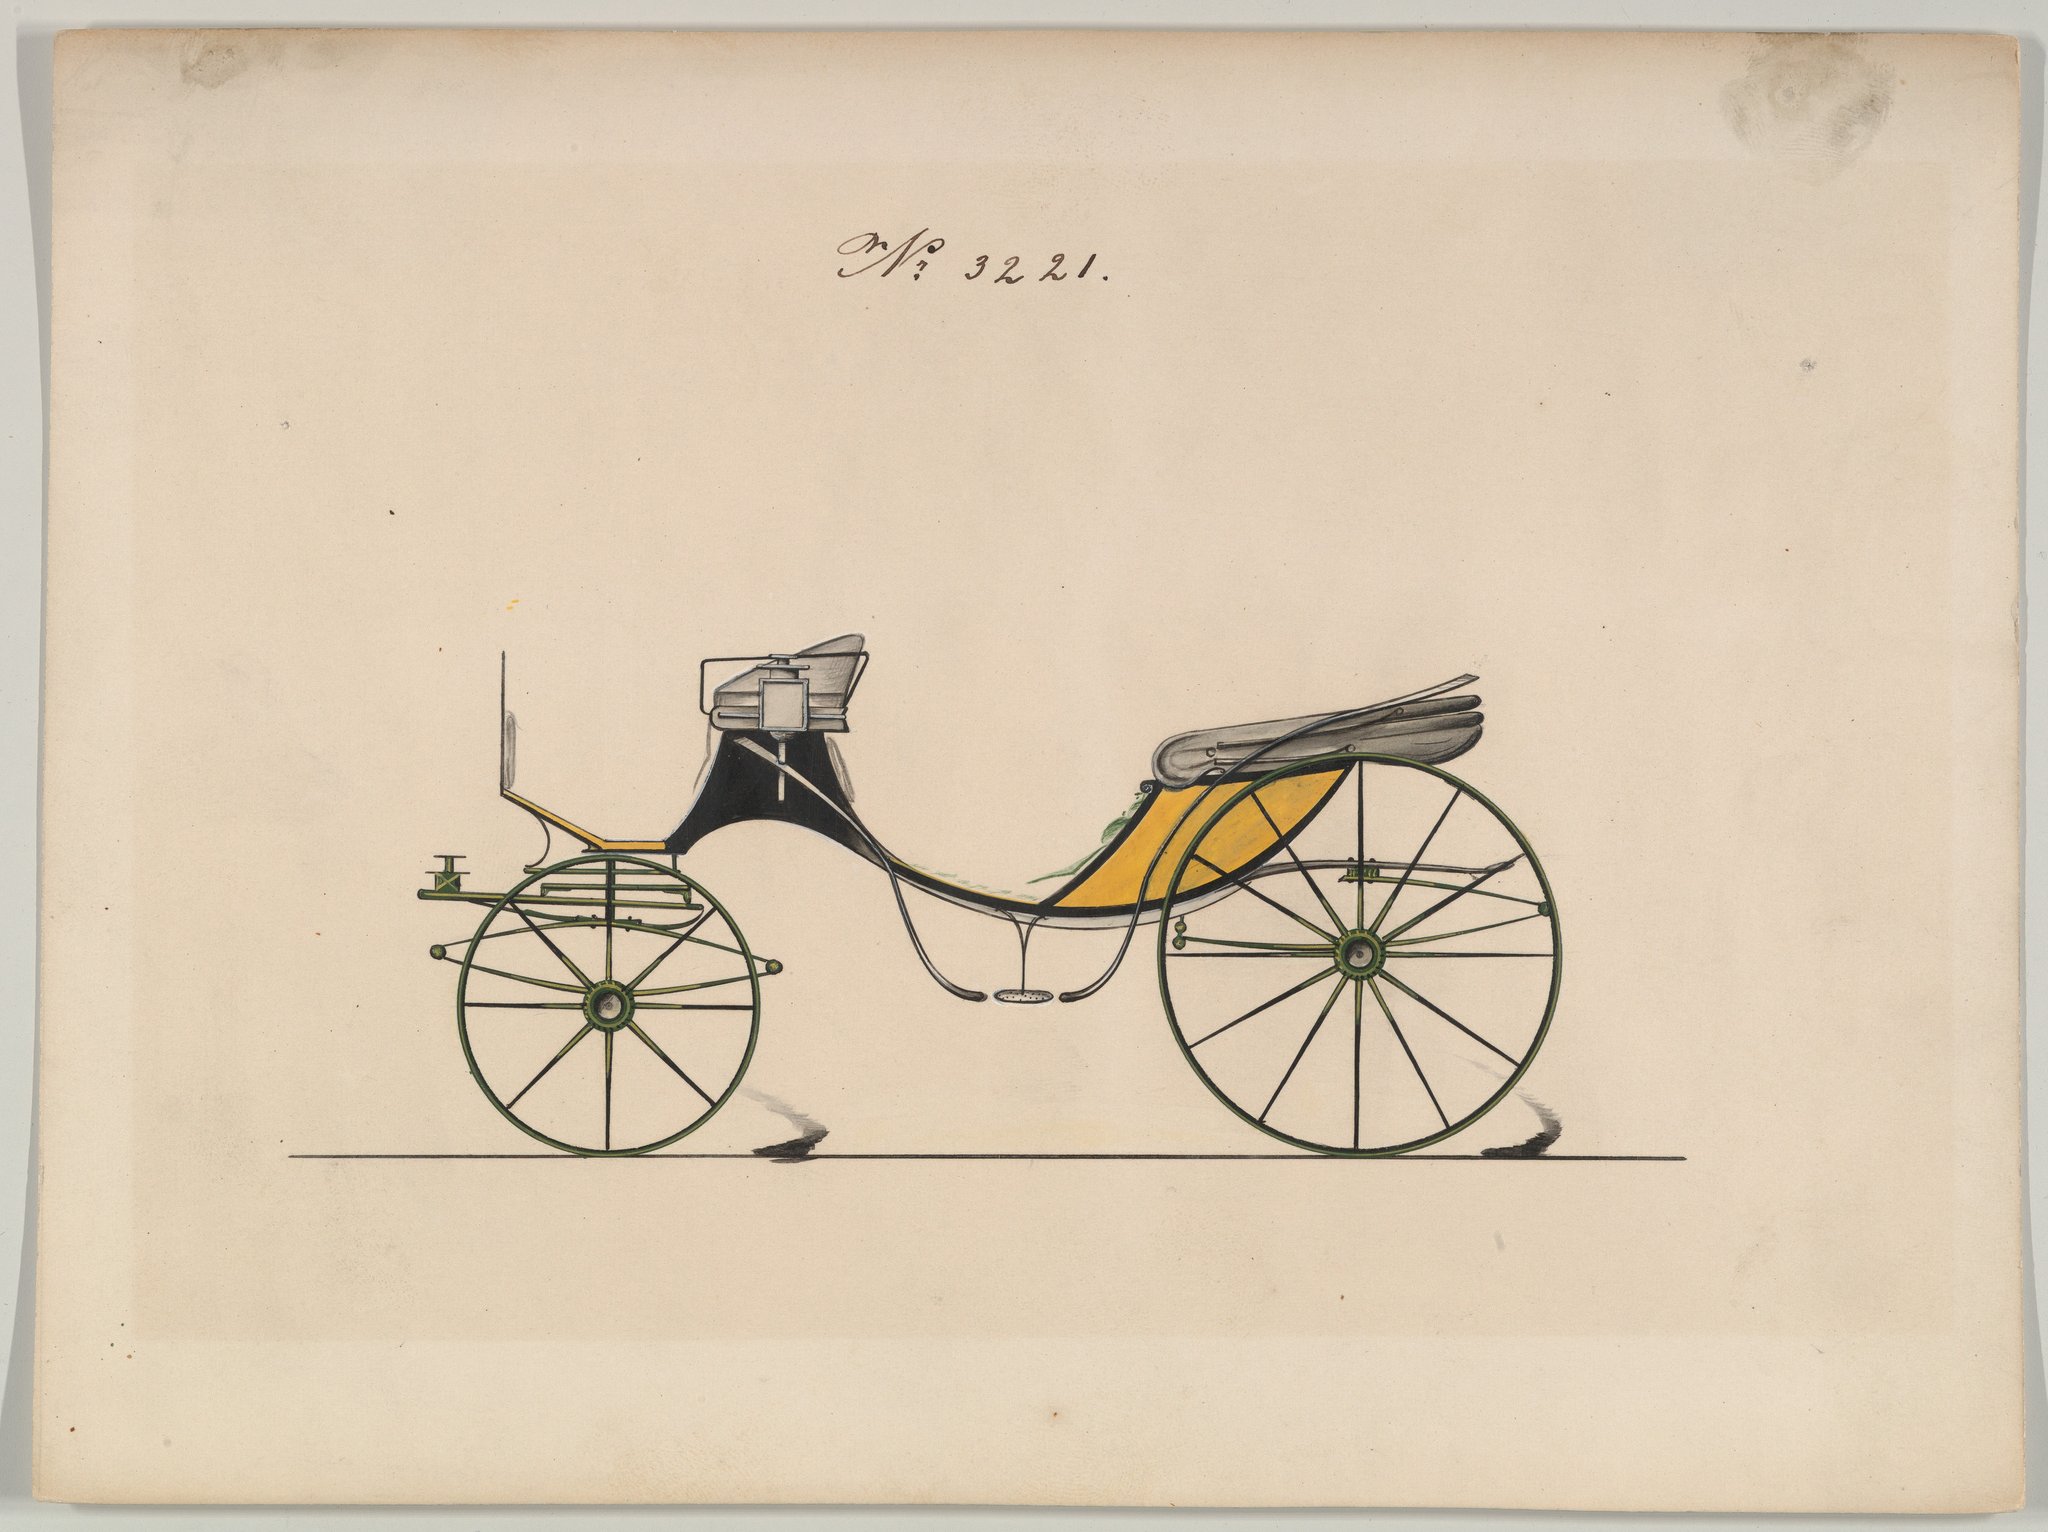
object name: drawing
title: Cabriolet #3221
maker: brewster & co.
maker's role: manufacturer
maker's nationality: american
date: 1876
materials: gouache, gum arabic, ink, watercolor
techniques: pen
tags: carriages